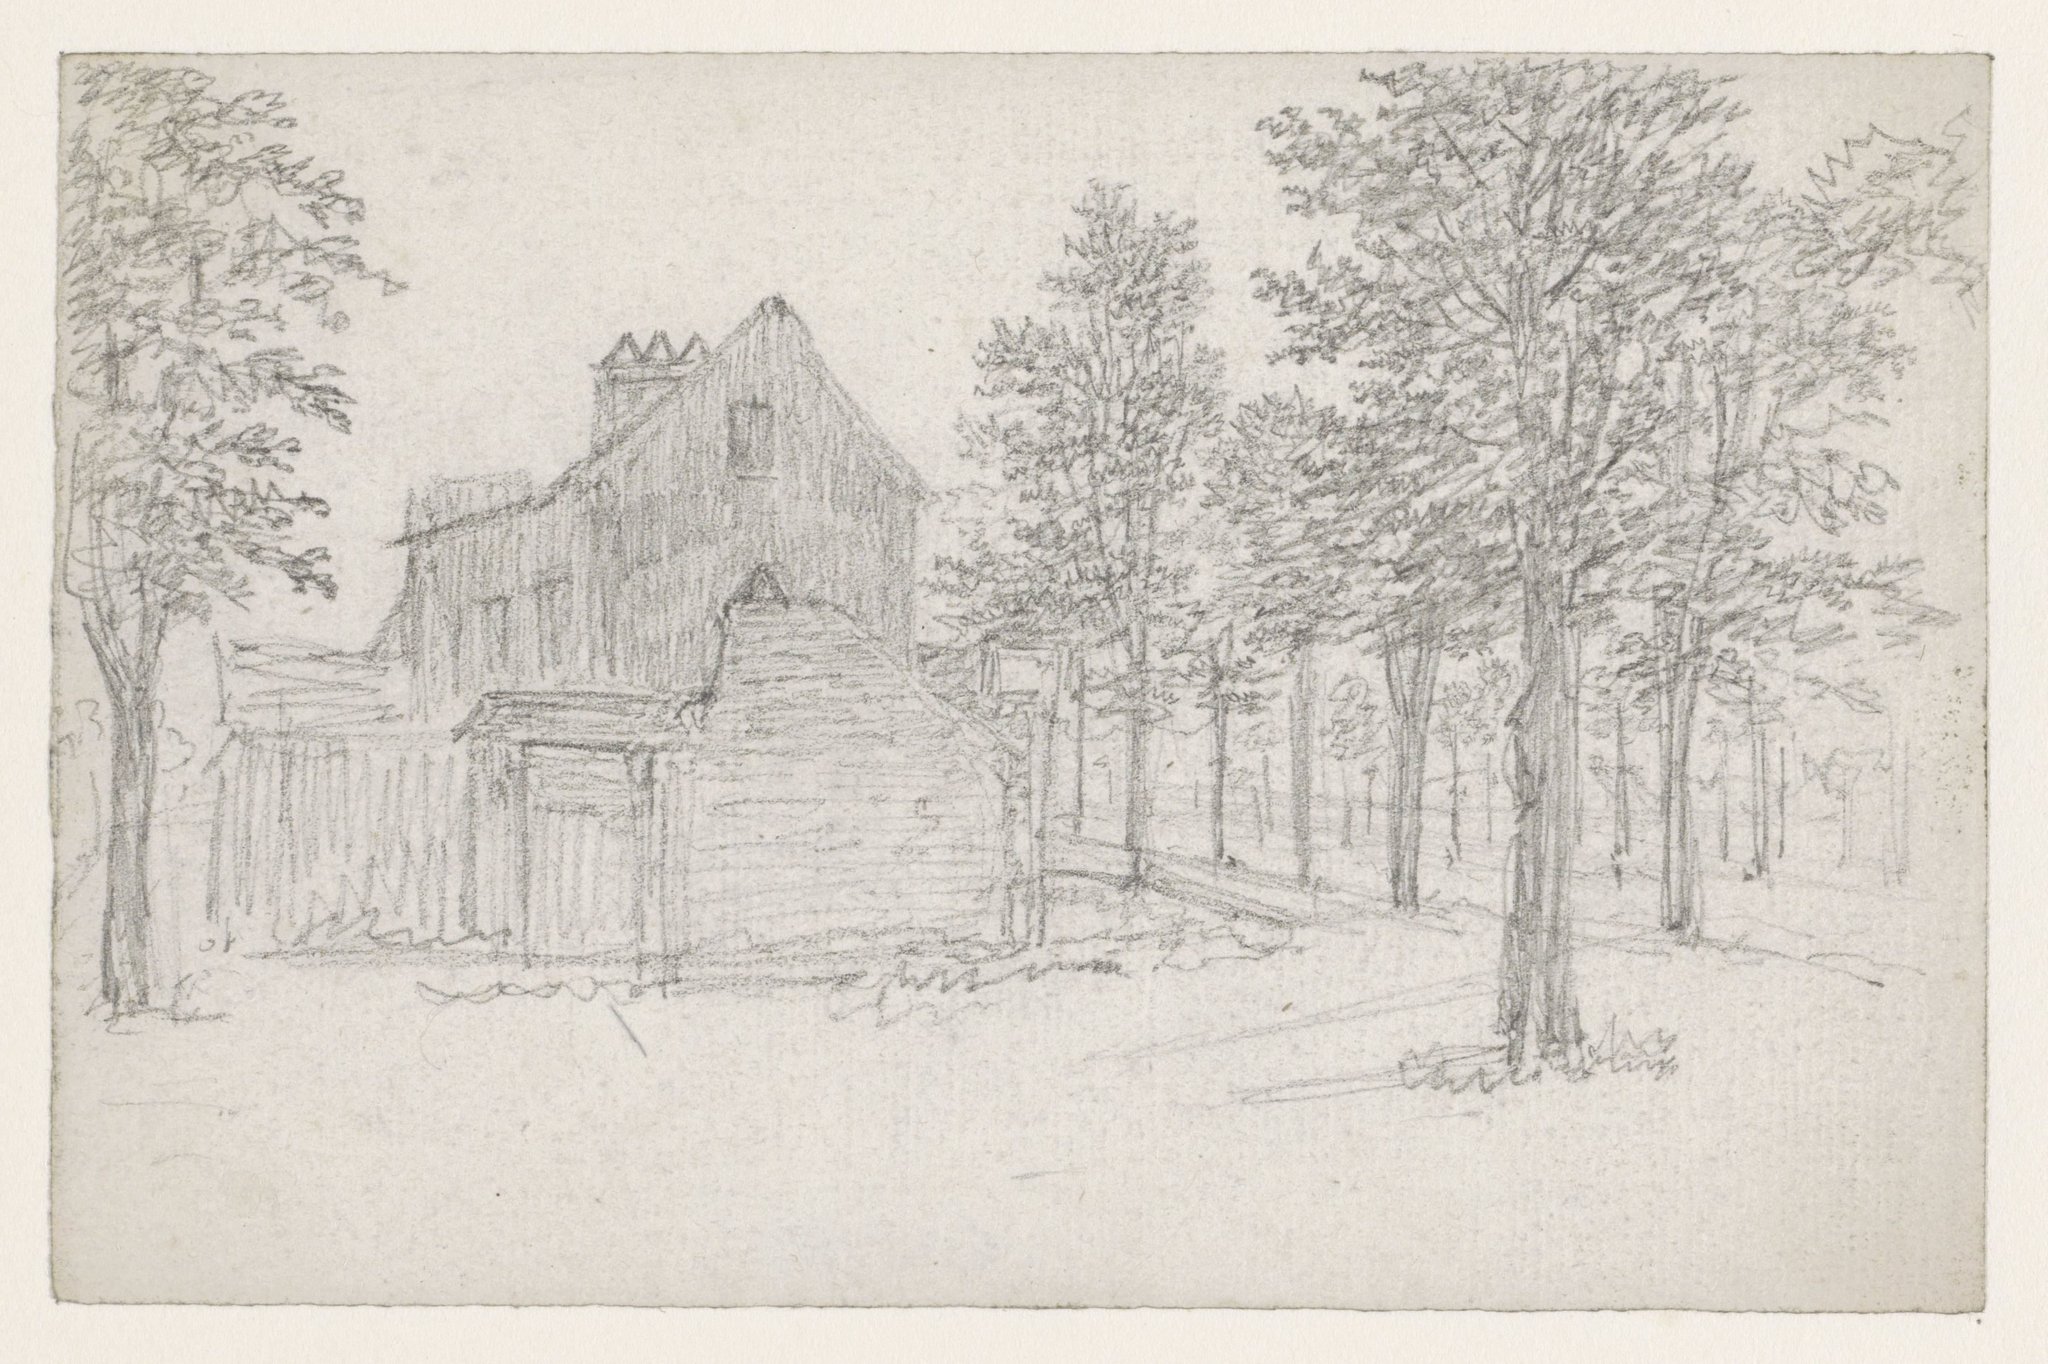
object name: drawing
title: Weg met bomen, waaraan links huizen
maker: georges michel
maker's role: draughtsman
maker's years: 1763-1843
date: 1773-1843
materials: paper, pencil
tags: public road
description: Een van 120 tekeningen, afkomstig uit een 19e eeuws album met tekeningen van Georges Michel.